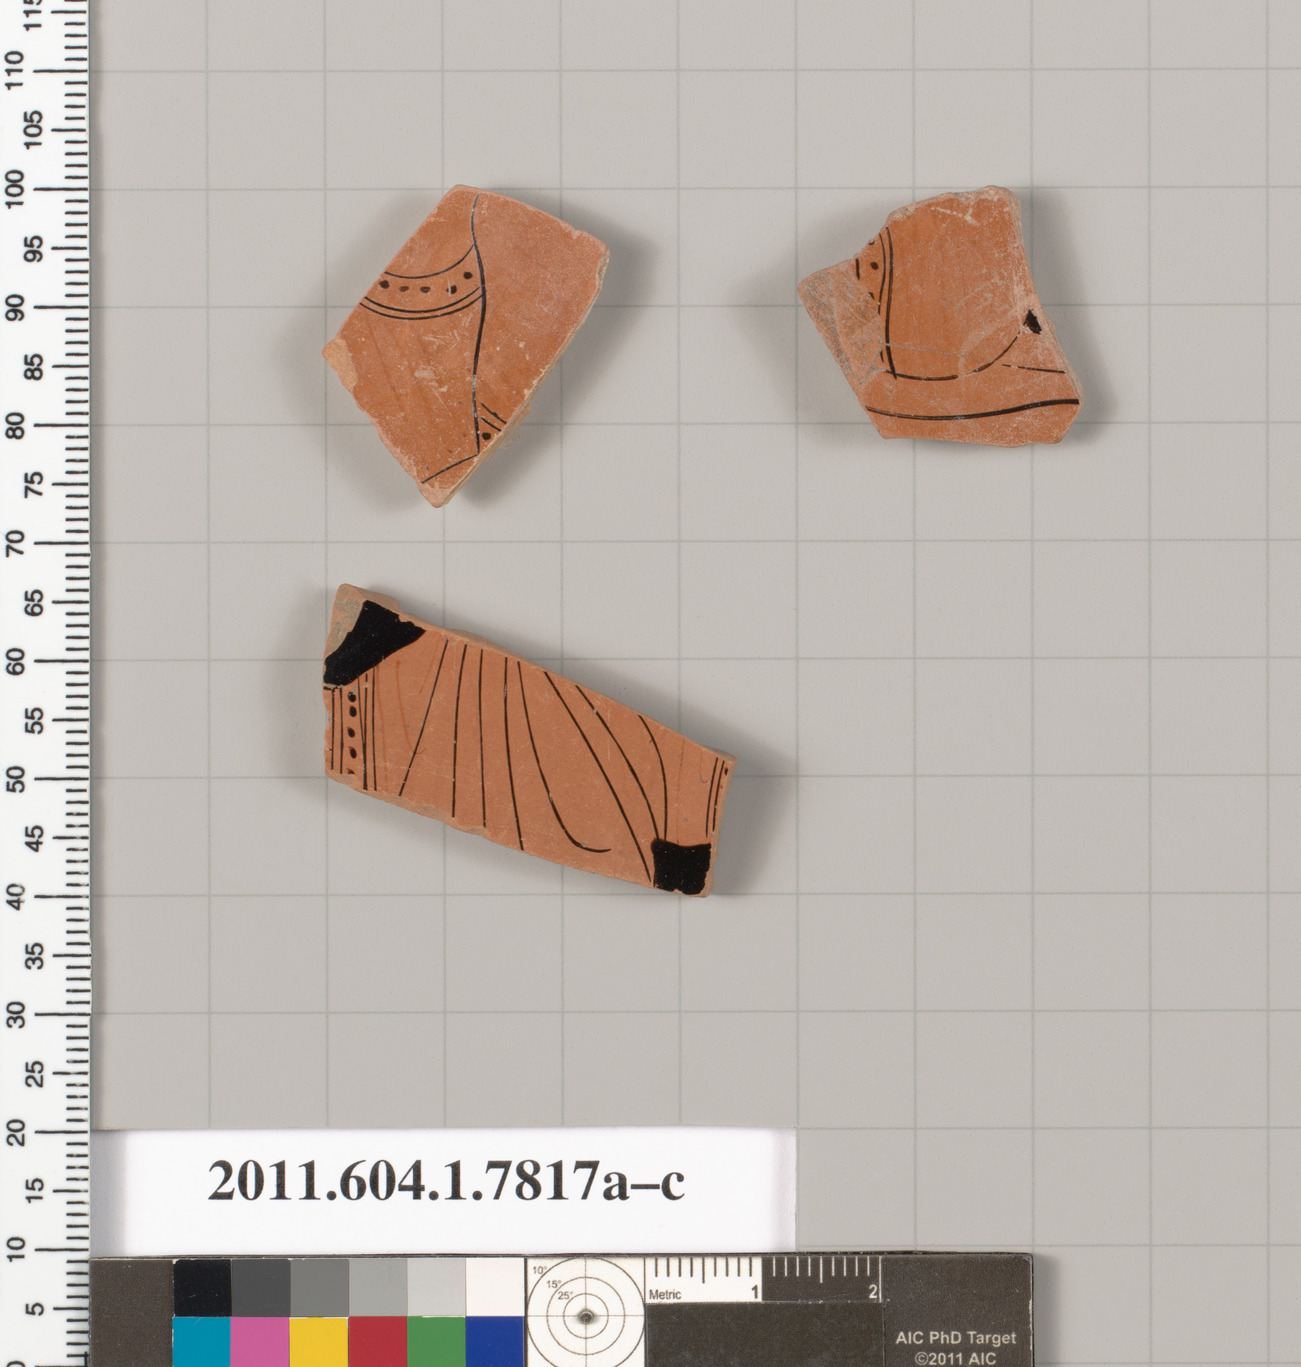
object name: kylix fragment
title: Terracotta fragments of a kylix (drinking cup)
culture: greek, attic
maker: sabouroff painter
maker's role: artist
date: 467-435 BCE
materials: terracotta